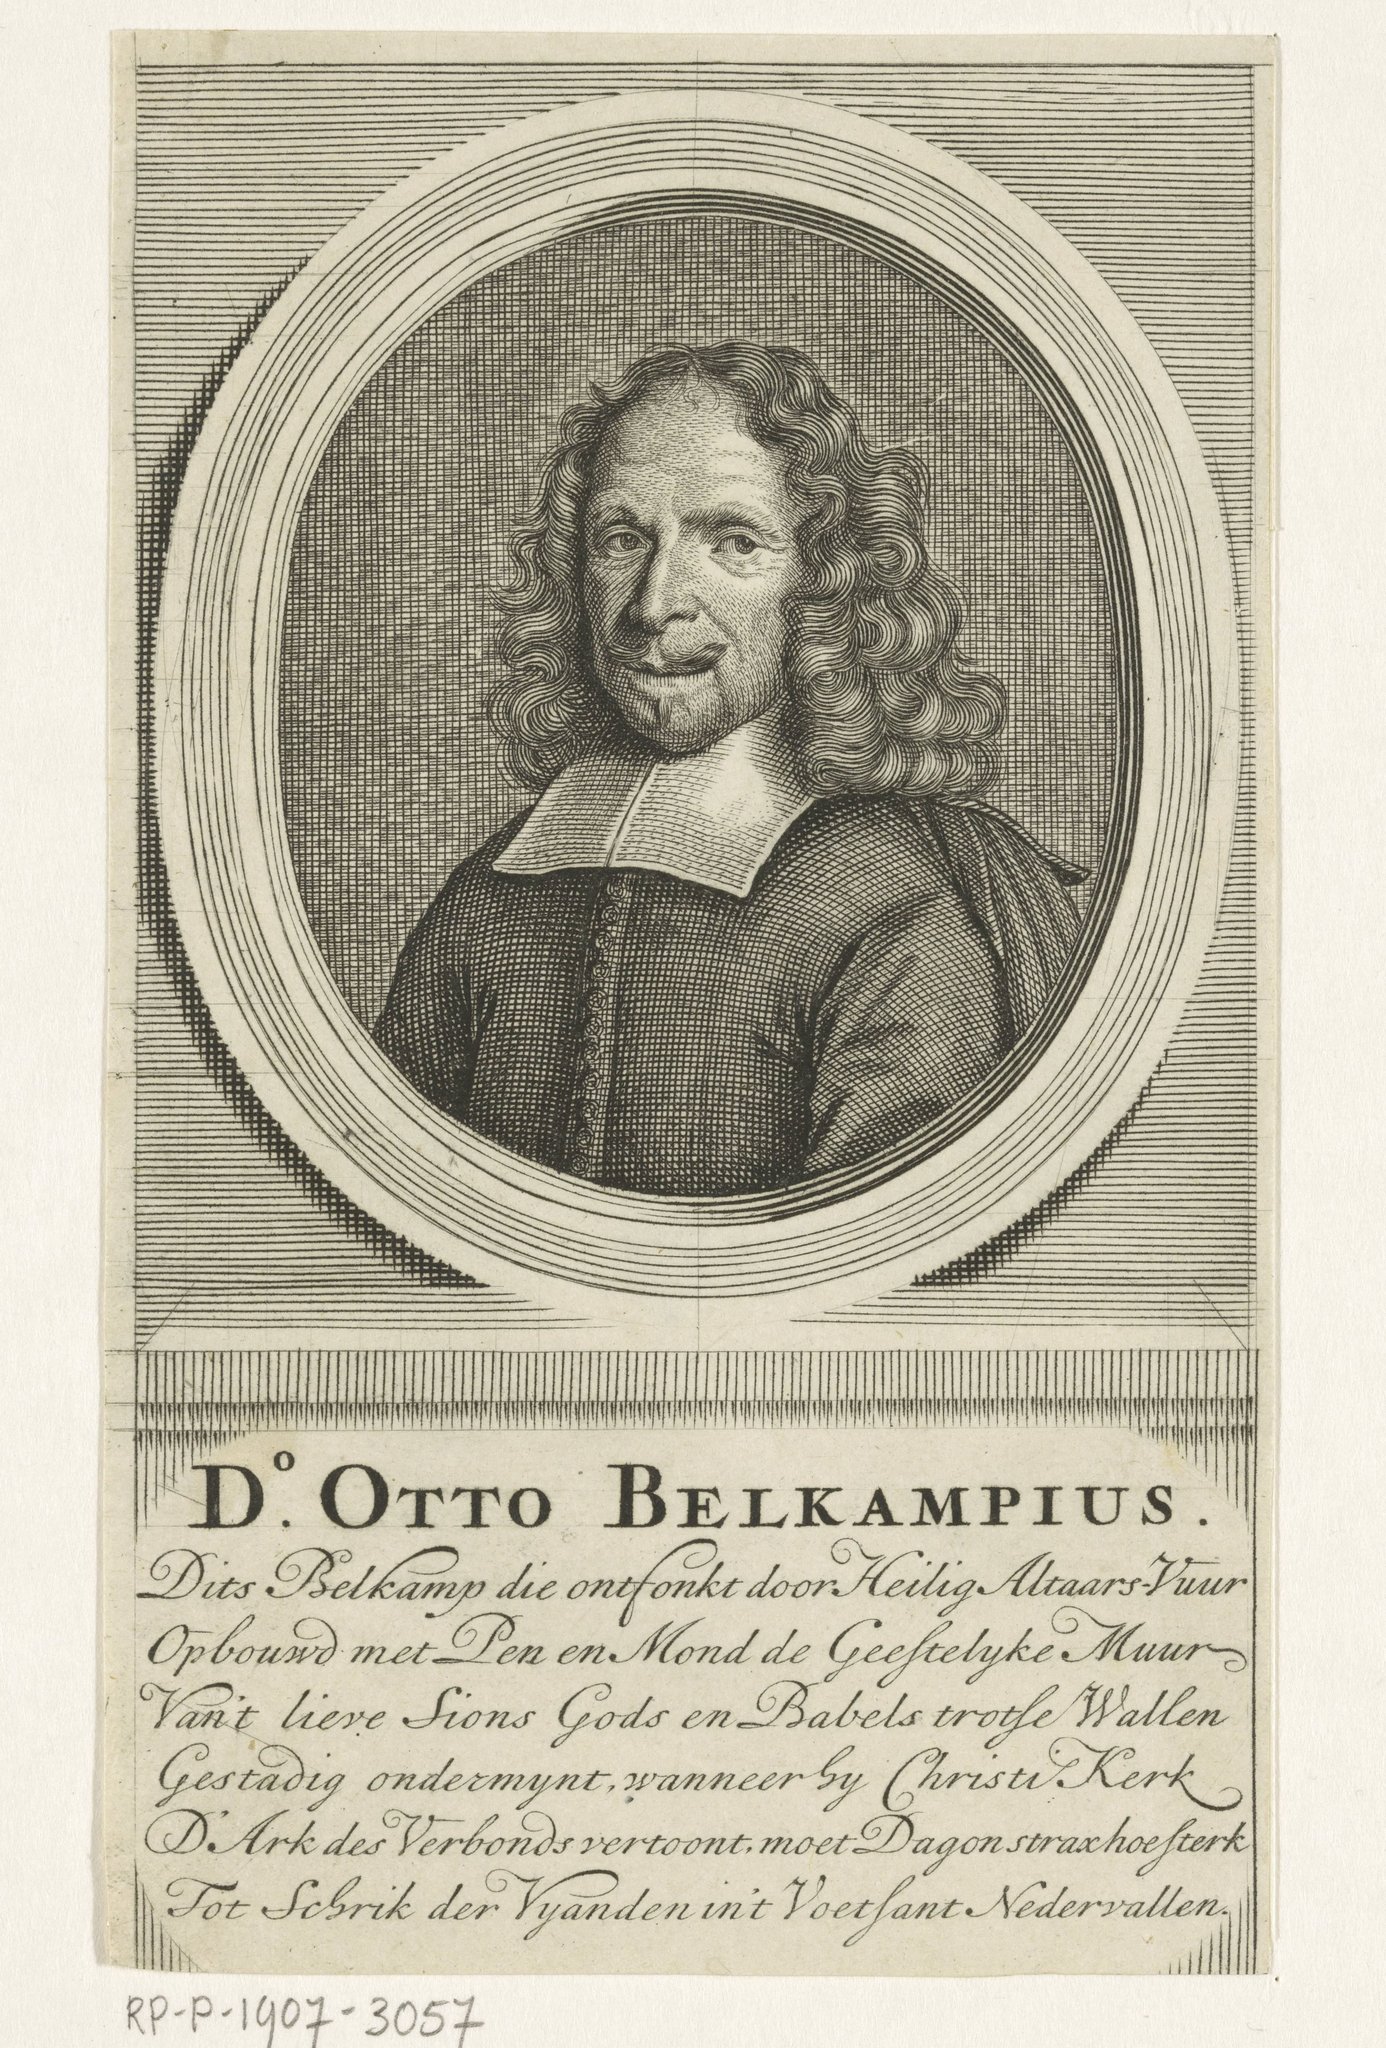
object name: print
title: Do. Otto Belkampius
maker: dancker danckerts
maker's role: print maker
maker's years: 1633-1666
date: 1643-1666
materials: paper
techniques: engraving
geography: netherlands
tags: functionaries and dignitaries (with name) ~ episcopal protestant churches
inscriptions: collector's mark: Lugt 2228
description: Niet beschreven bij Hollstein. Vergelijk een andere staat van dit portret in de collectie van het Stadsarchief Amsterdam, met afbeelding op http://beeldbank.amsterdam.nl.